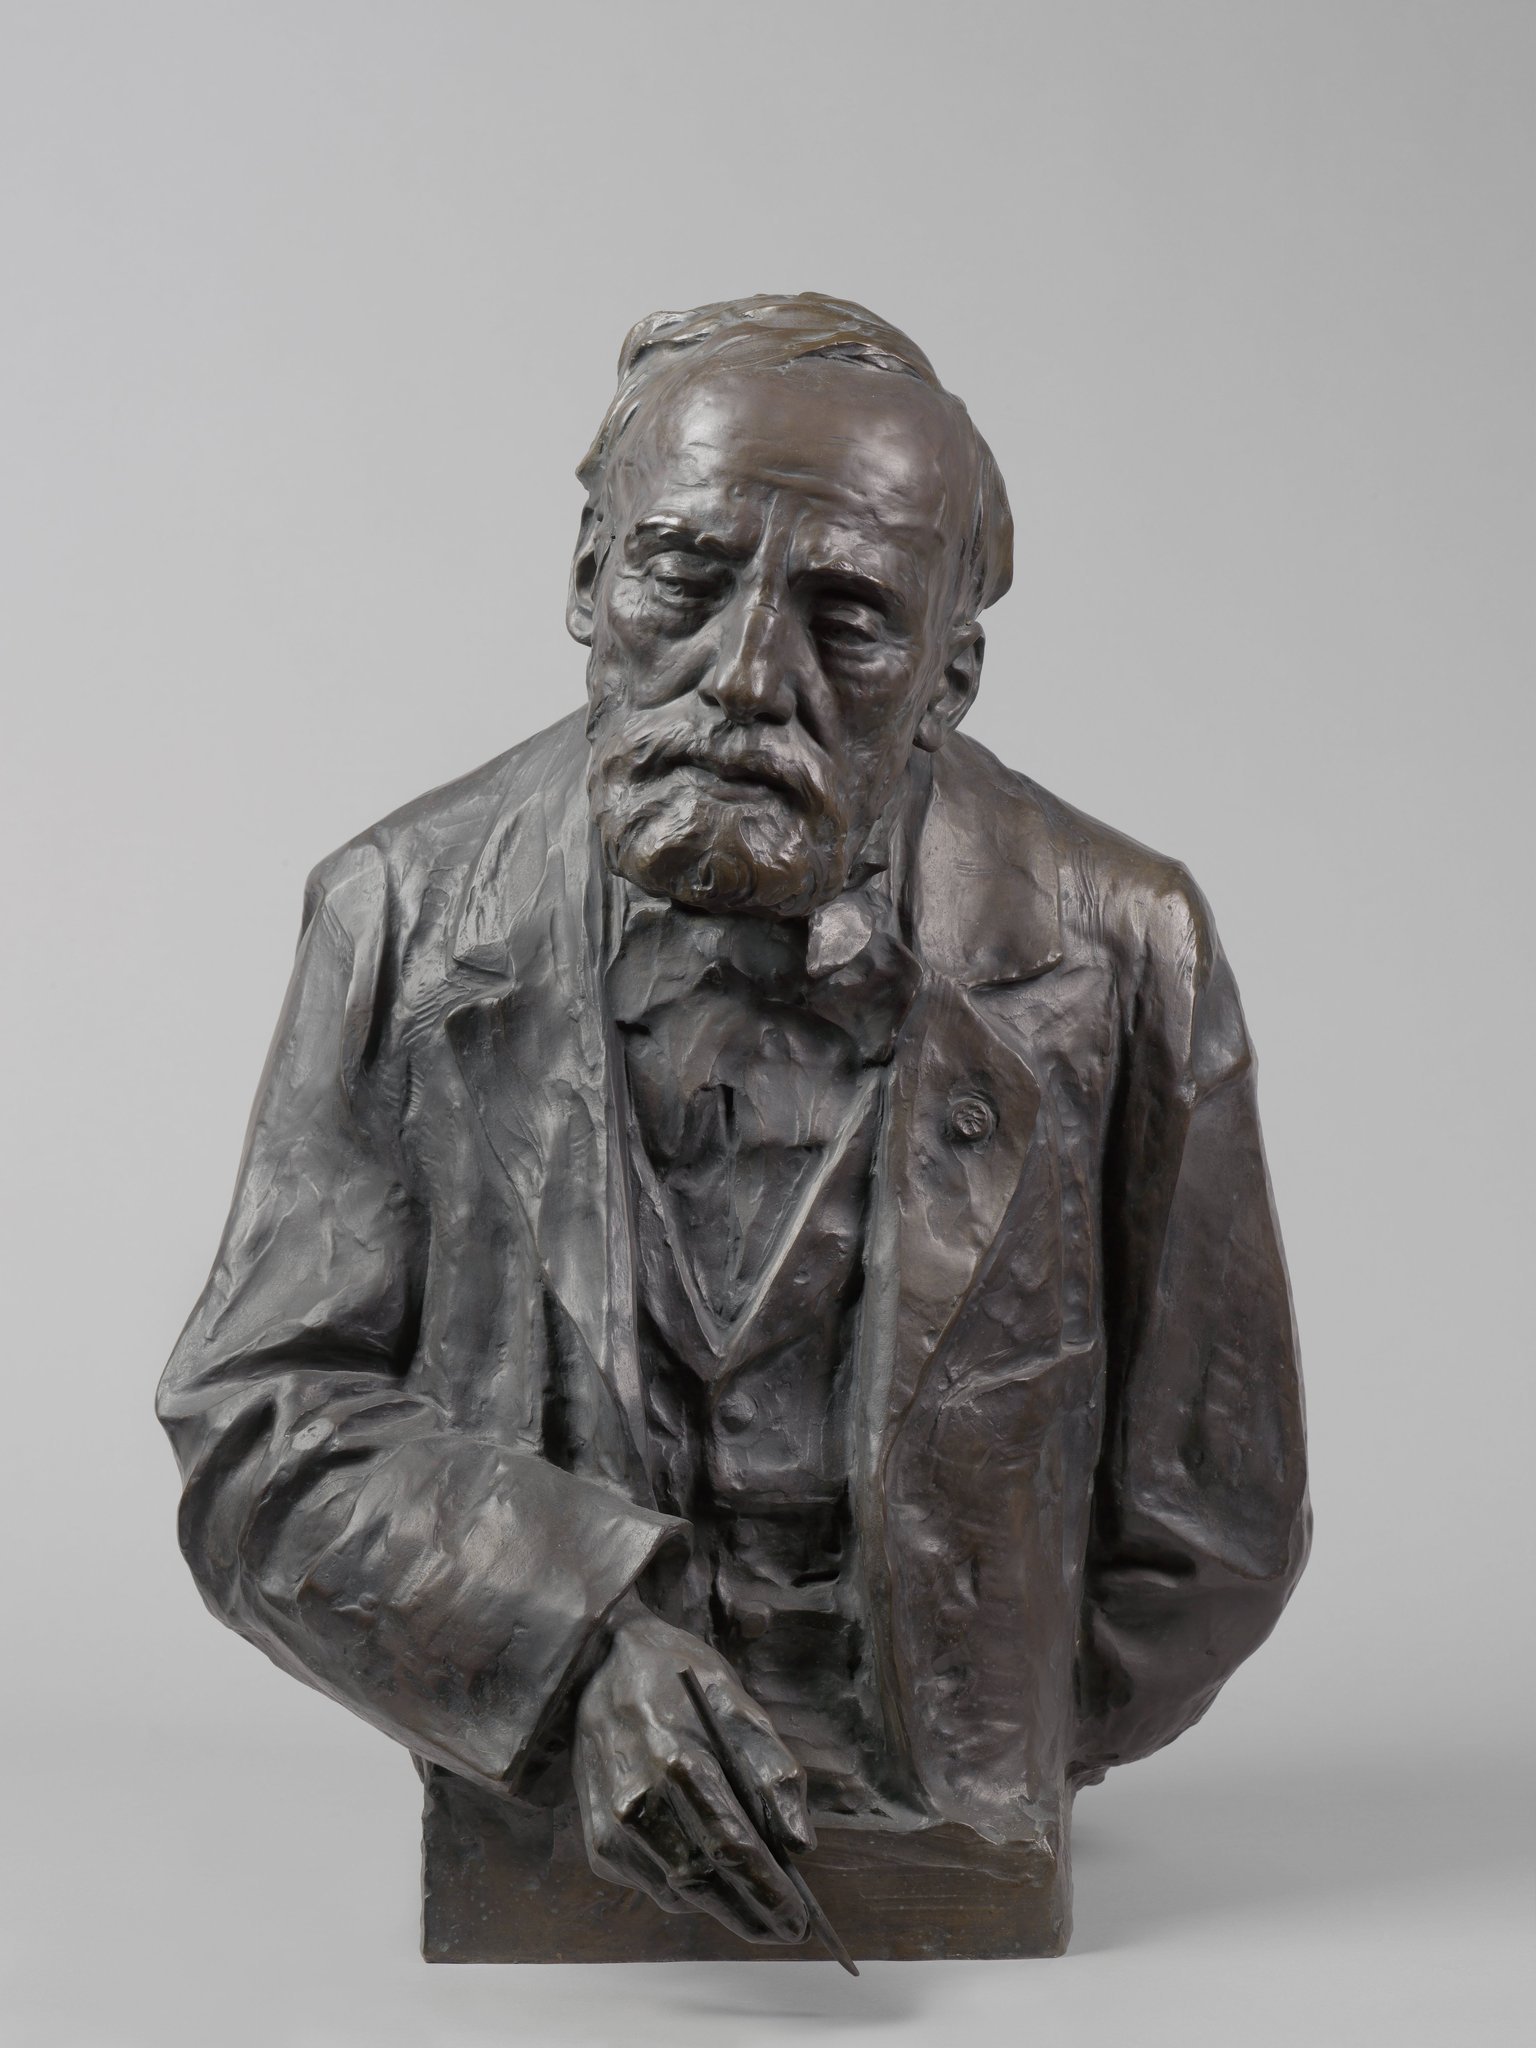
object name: sculpture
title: Halffiguur van Jozef Israels (1824-1911), schilder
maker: toon dupuis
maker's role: sculptor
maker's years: 1877-1937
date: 1887-1937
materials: bronze